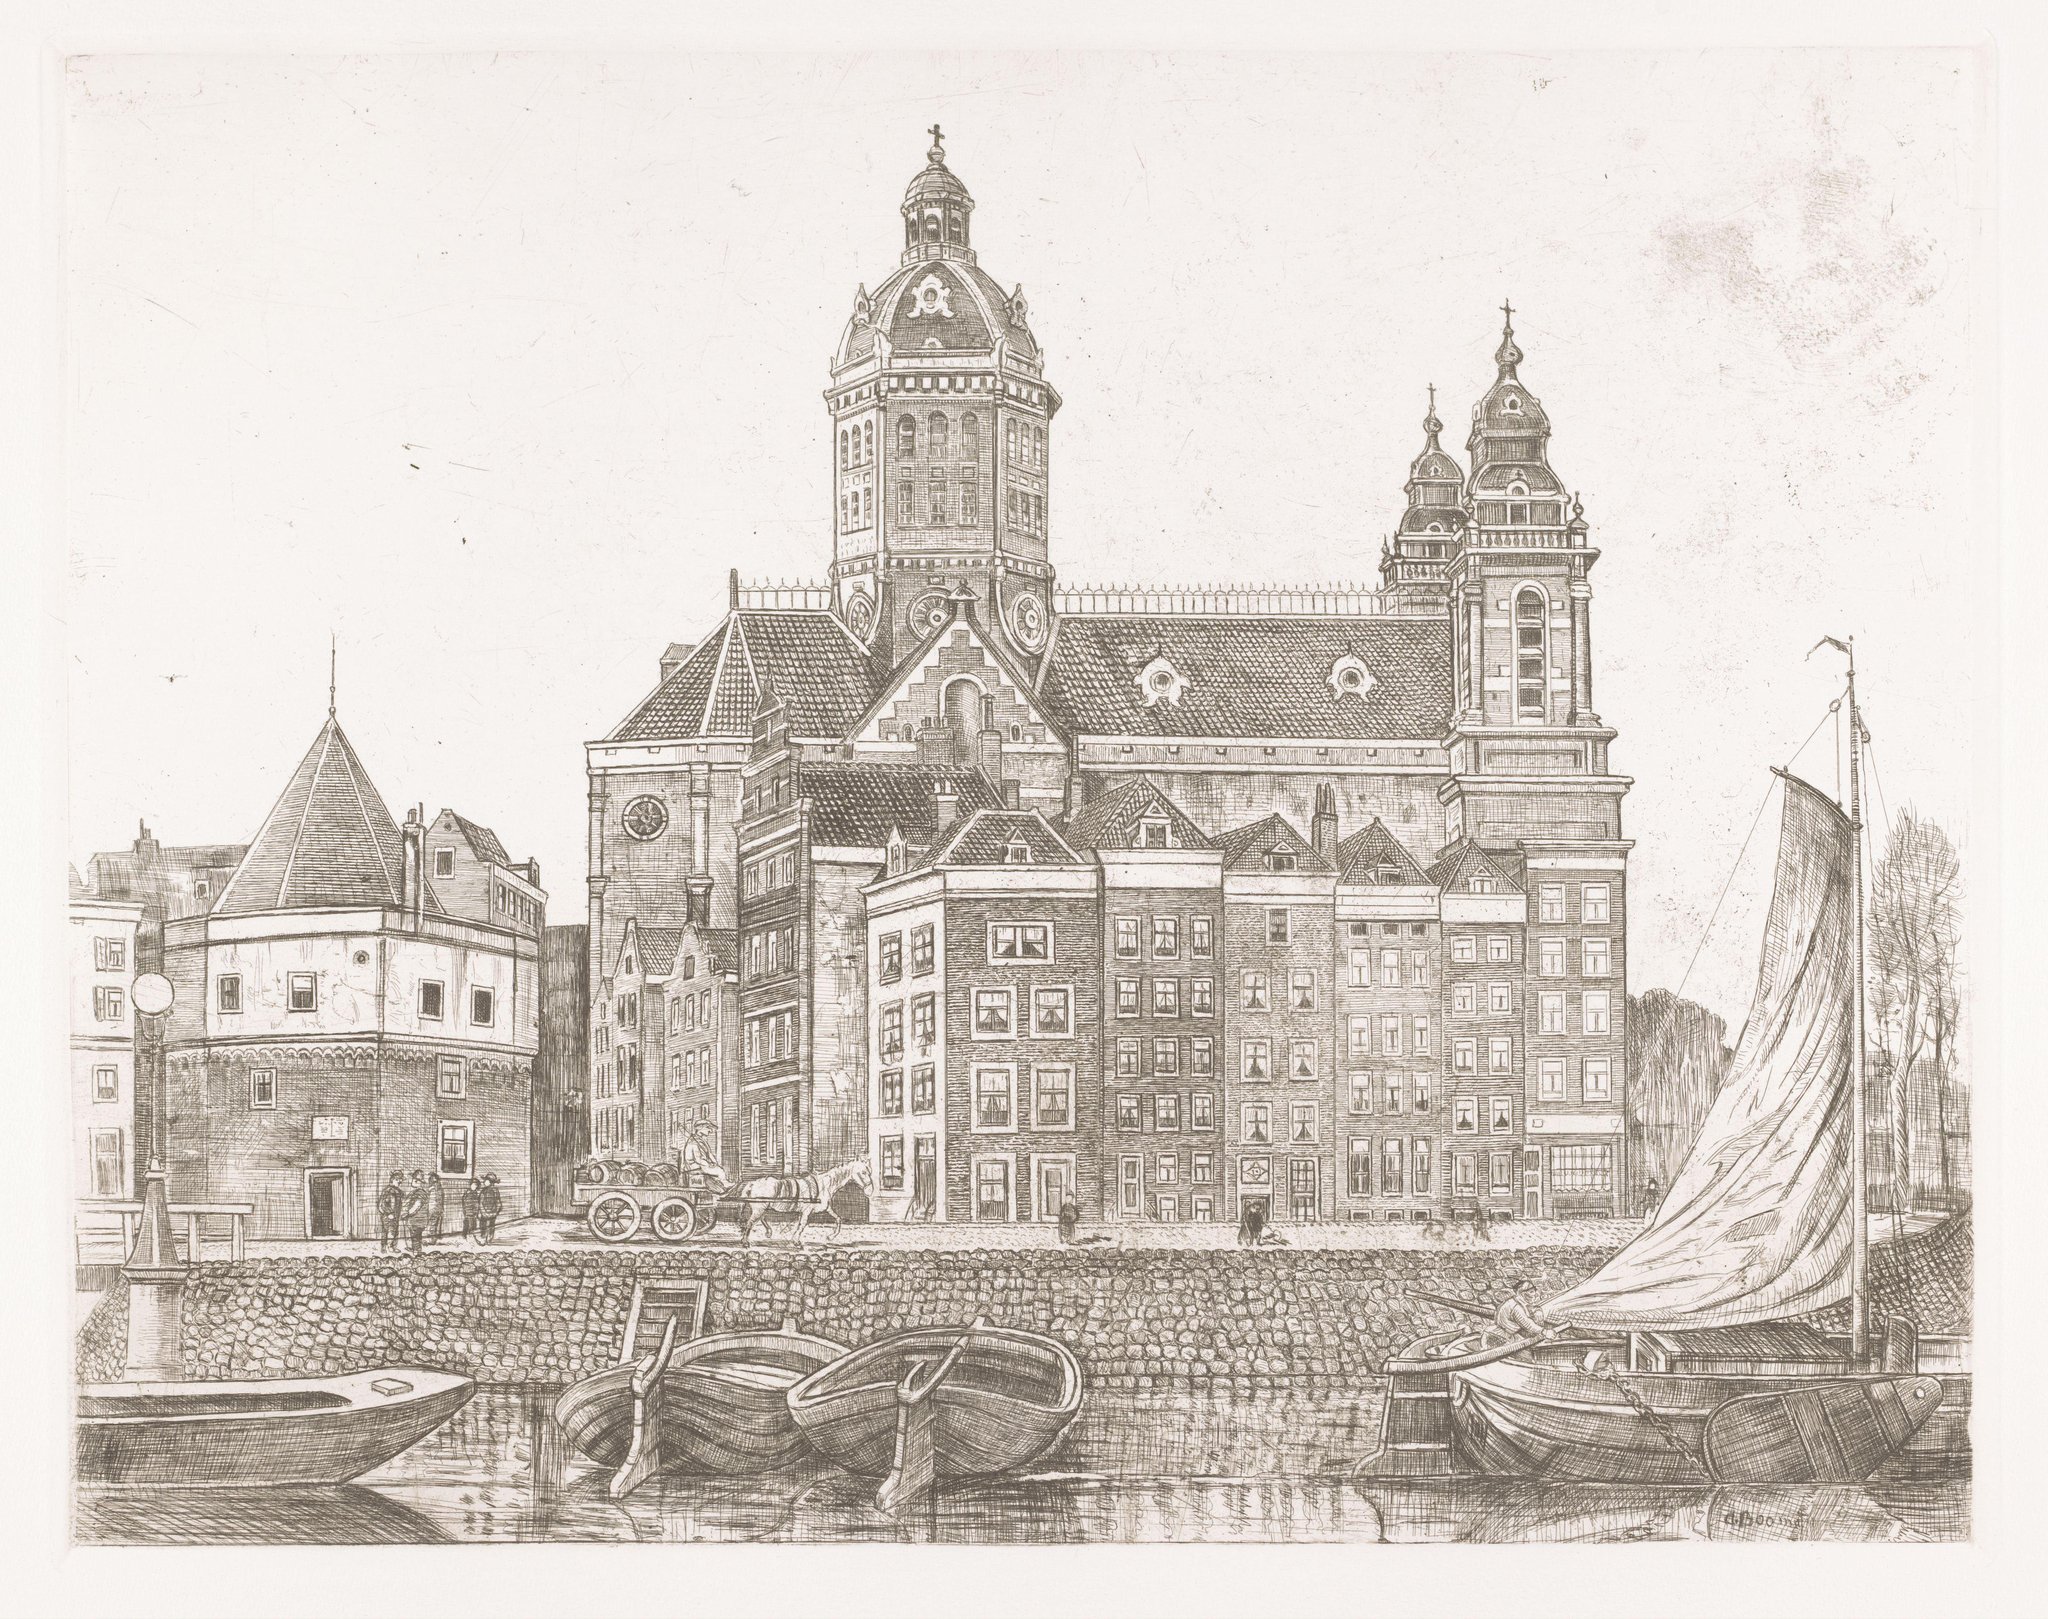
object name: print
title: Gezicht op de Sint Nicolaaskerk en Schreierstoren in Amsterdam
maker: alex boom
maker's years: 1862-1943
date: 1872-1943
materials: paper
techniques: etching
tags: city-view, and landscape with man-made constructions, sailing-ship, sailing-boat, building of church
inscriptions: collector's mark: Lugt 2228